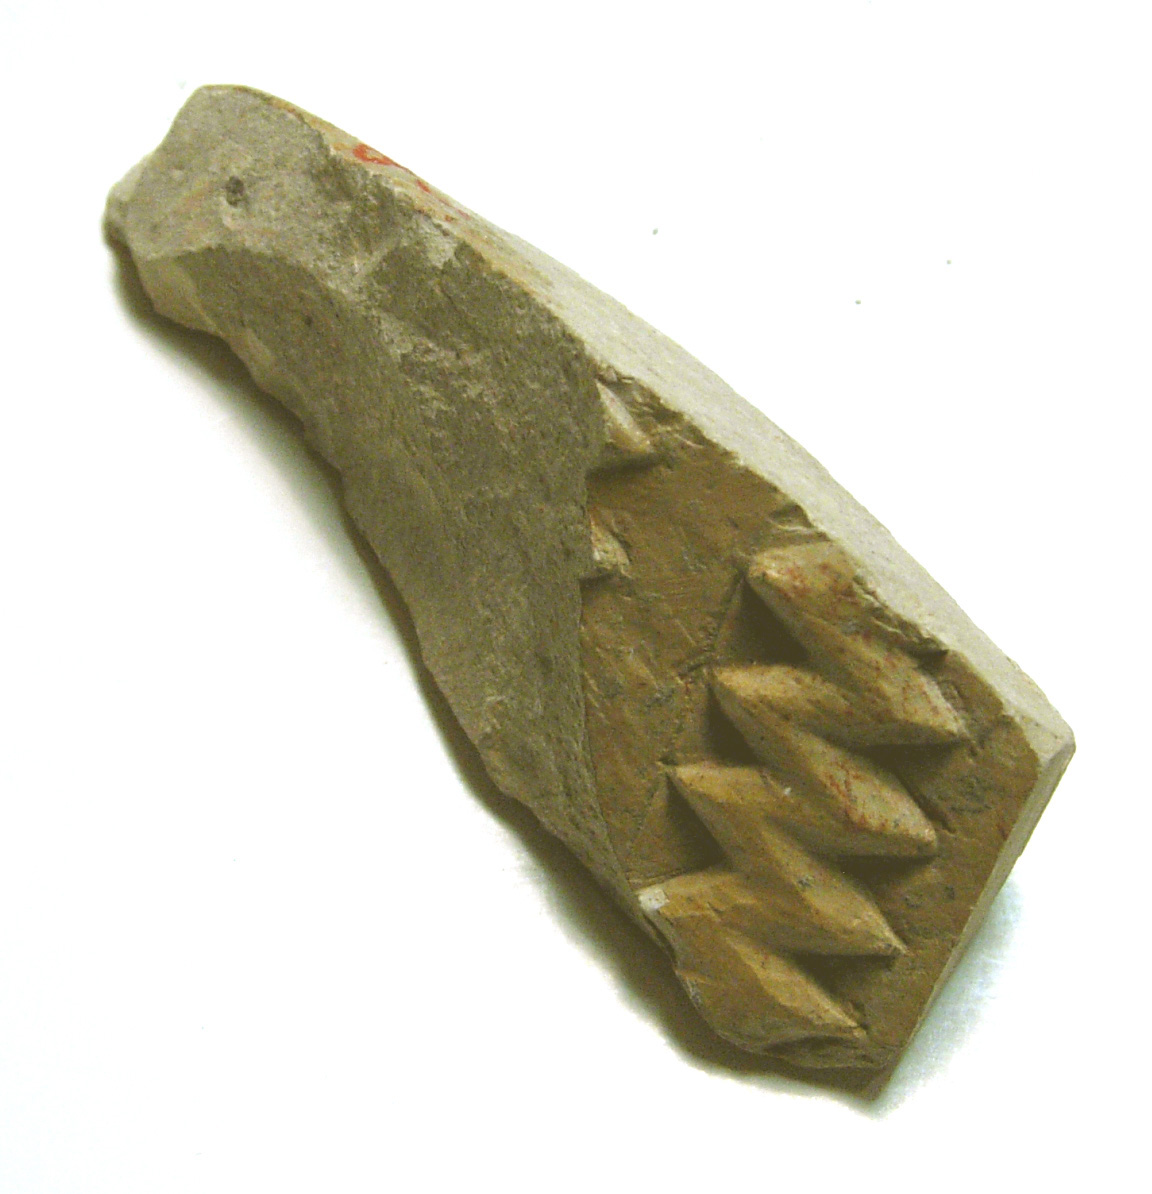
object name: relief, tomb of nespekashuty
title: Raised relief fragment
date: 664-610 BCE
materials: limestone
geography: egypt